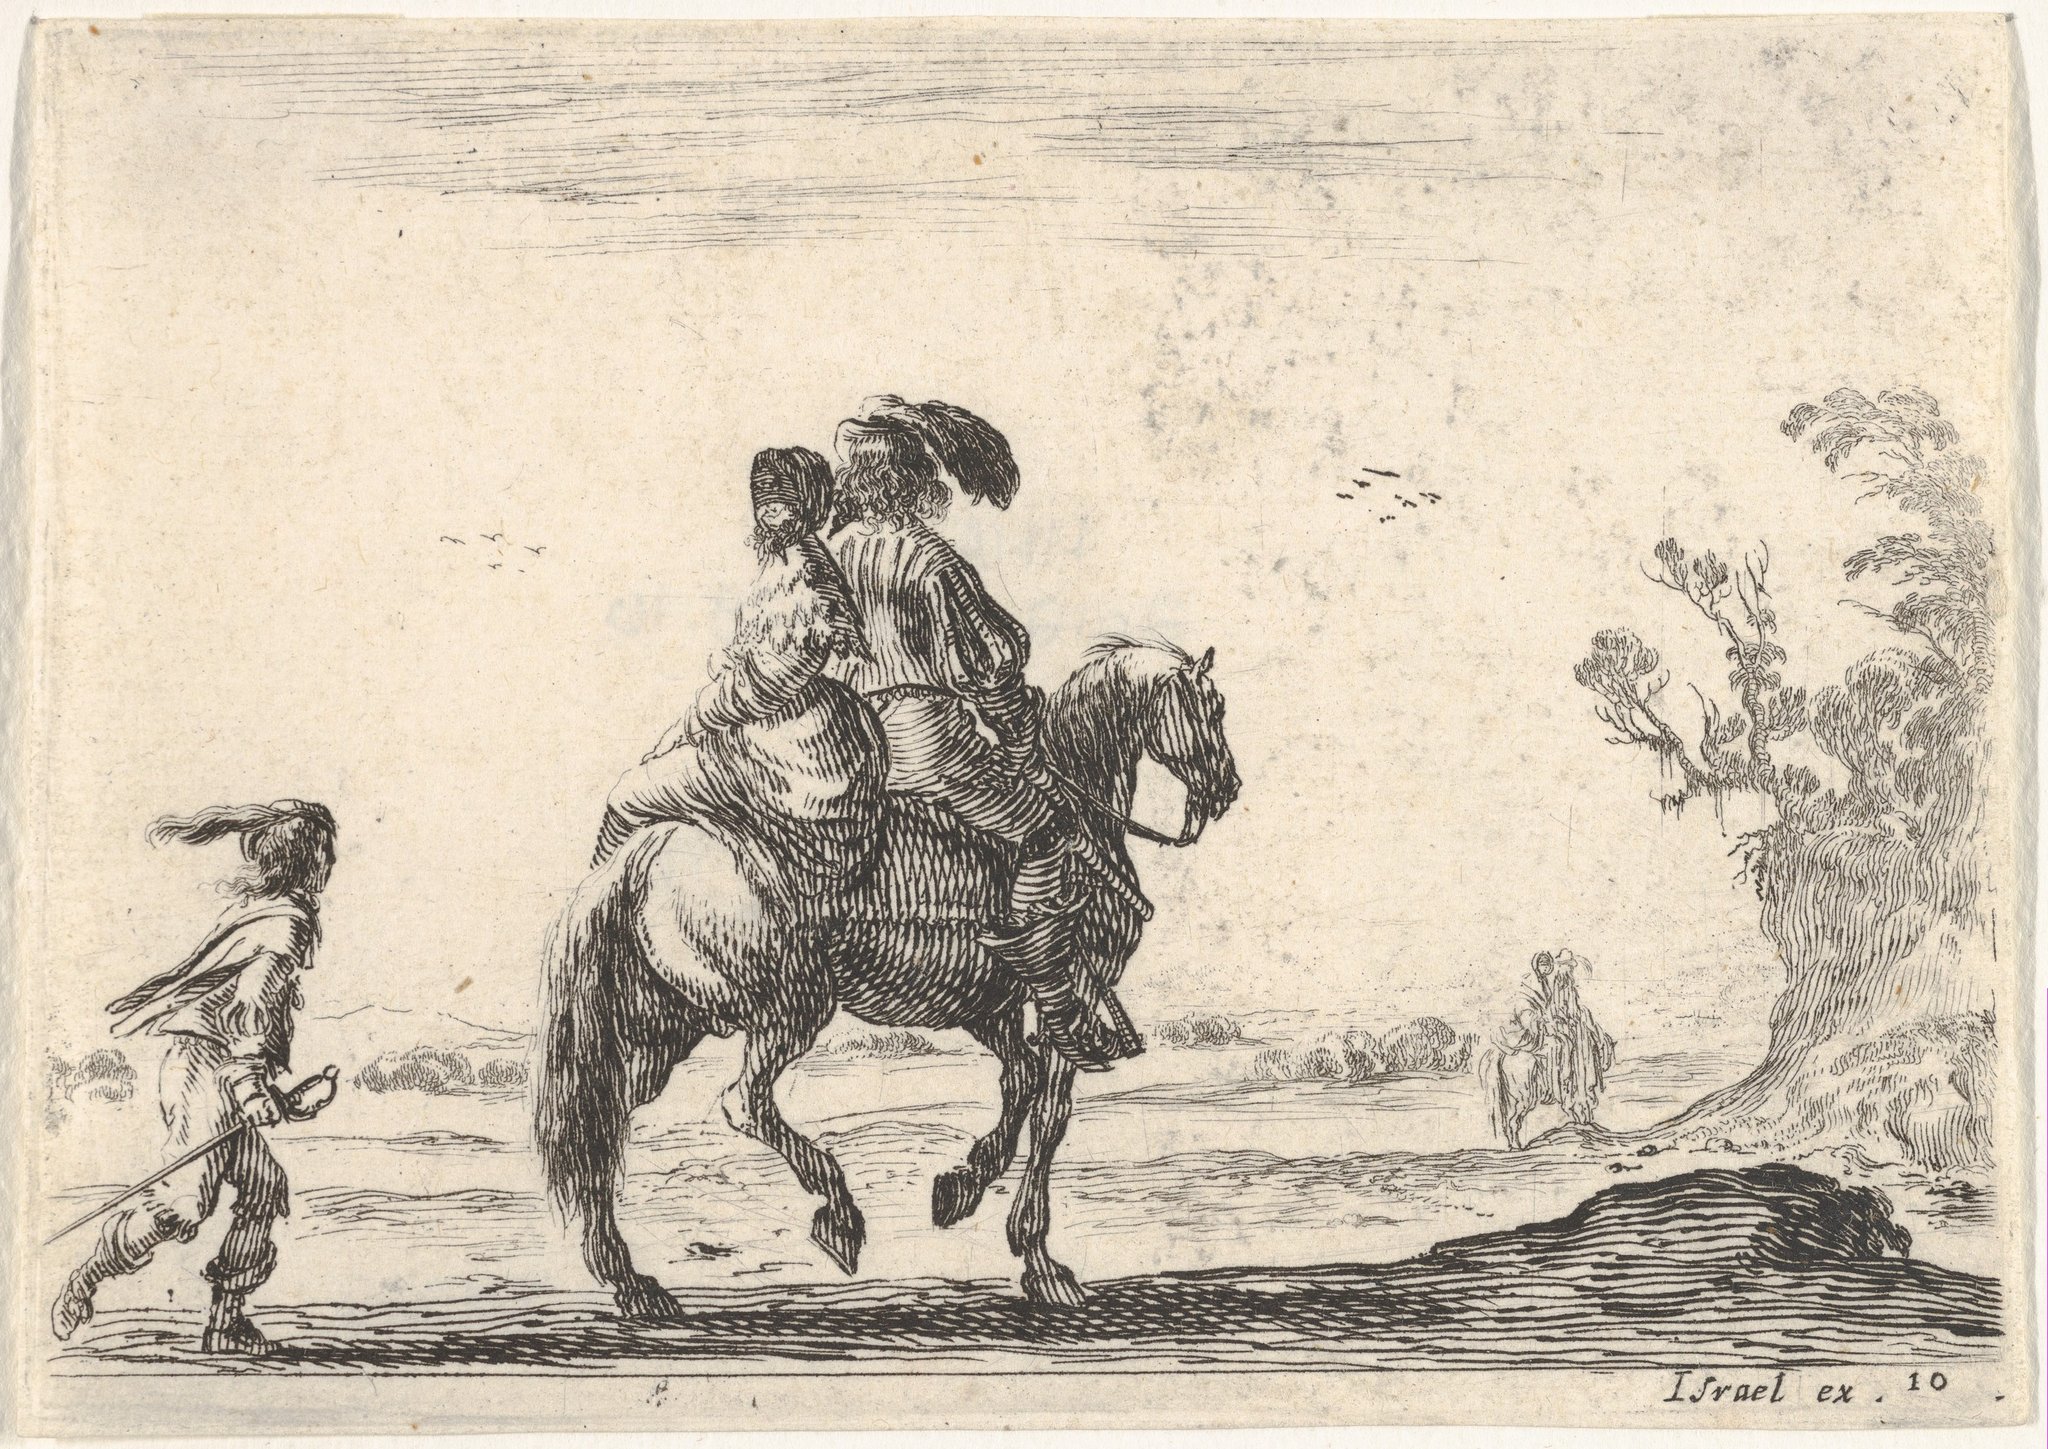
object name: print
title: Plate 10: a horseman and a woman, seen from behind, riding towards the right with a young man following them to left, another horseman and woman to right in the background, from "Various Figures" (Agréable diversité de figures)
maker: stefano della bella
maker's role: artist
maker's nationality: italian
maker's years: 1610-1664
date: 1642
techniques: etching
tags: men,women,horses